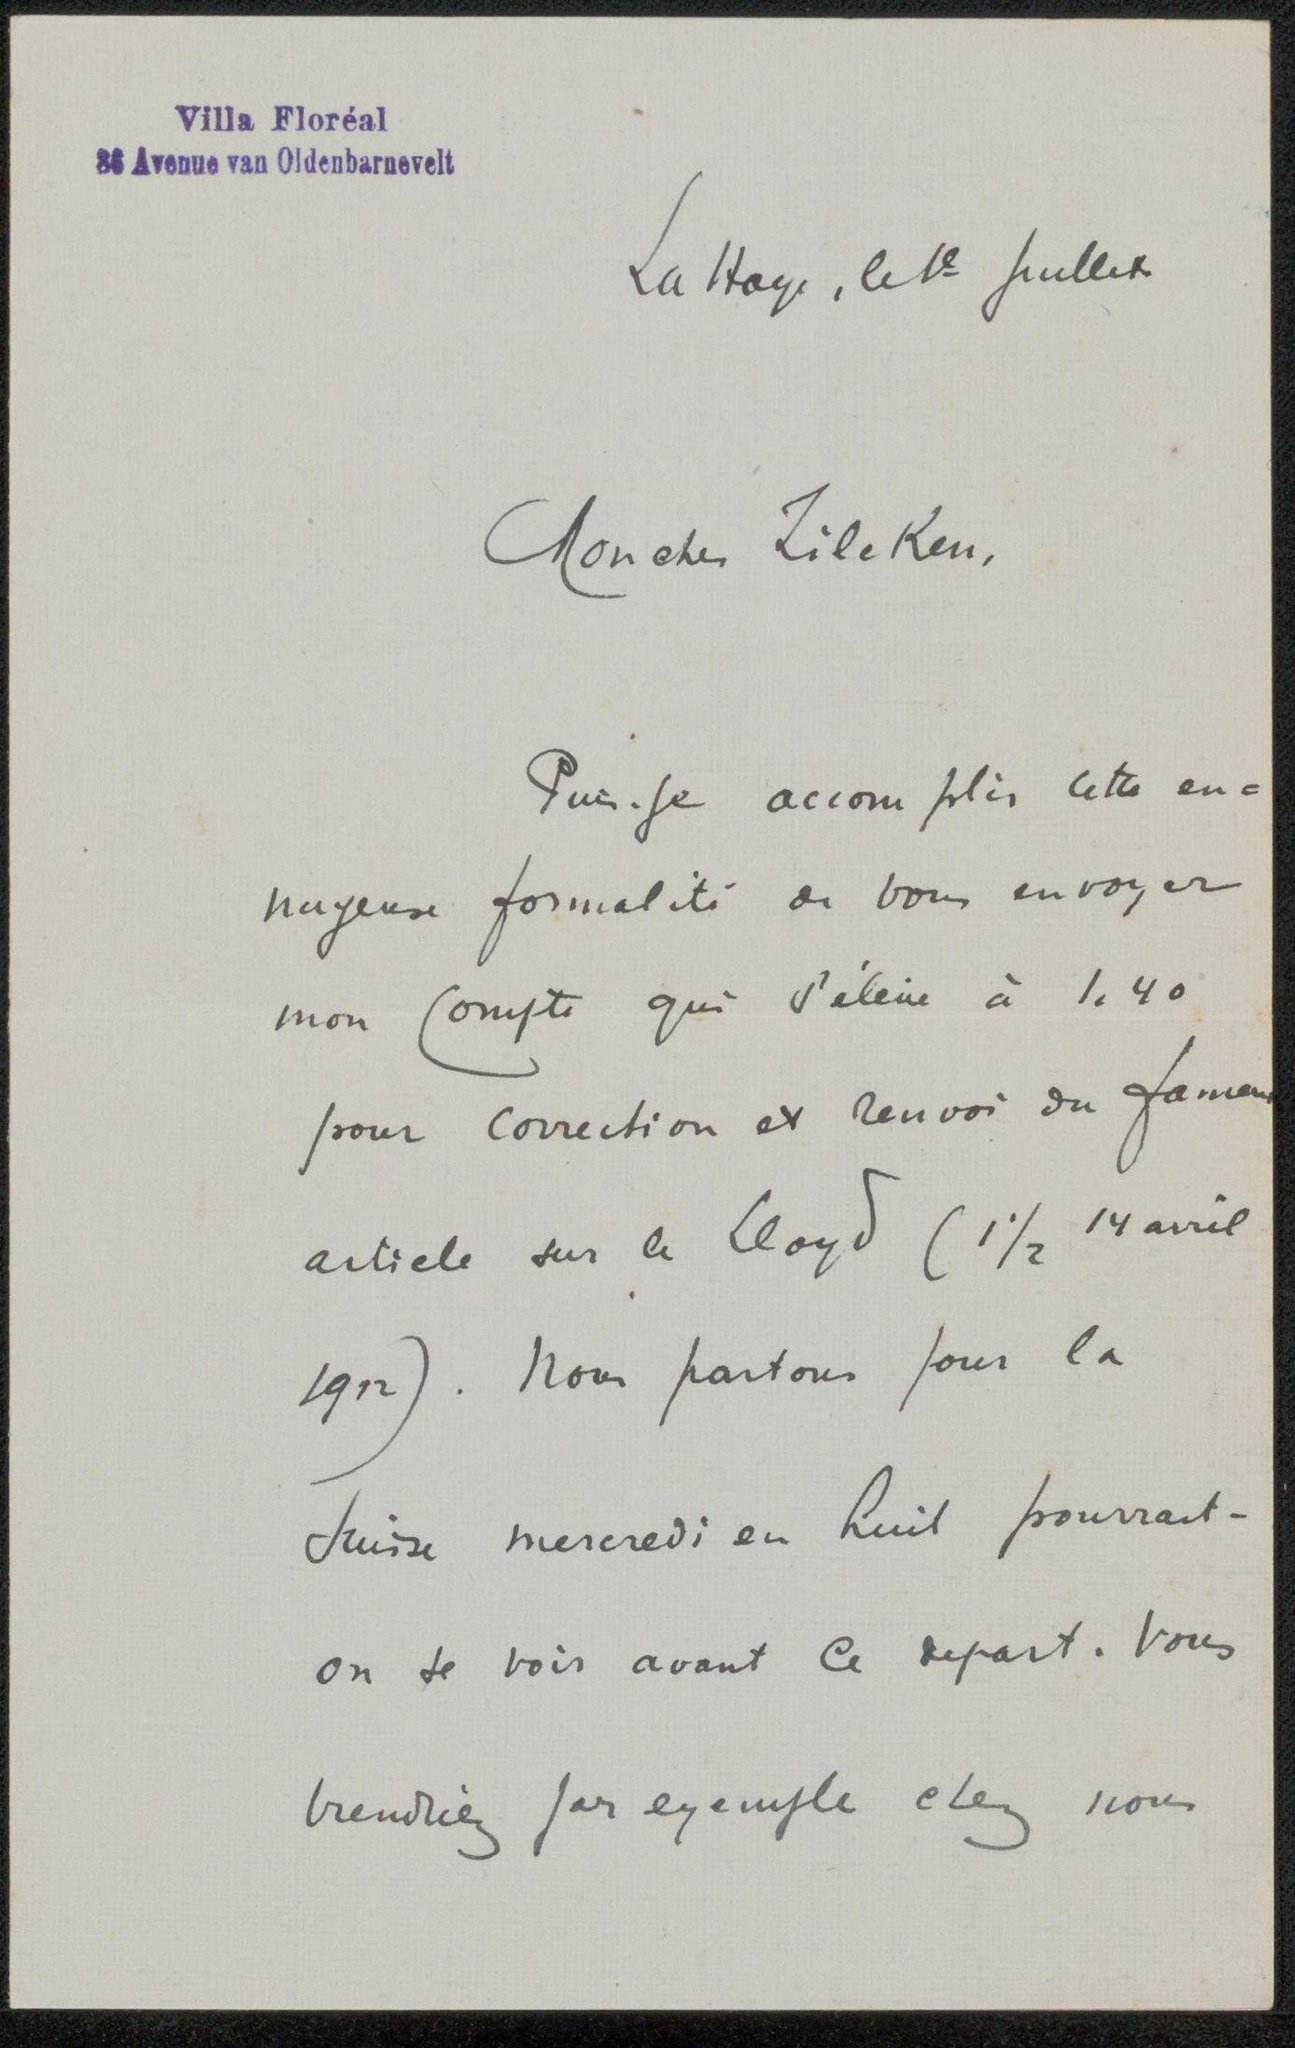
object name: letter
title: Brief aan Philip Zilcken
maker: léon paschal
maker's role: schrijver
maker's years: 1873-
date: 1912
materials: ink, paper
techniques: pen, writing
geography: the hague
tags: painter, draughtsman, philip zilcken, travelling; tourism, printed matter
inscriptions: collector's mark: ‘RPK’, inscription: ‘Villa Floréal/ 86 Avenue van Oldenbarnevelt.’